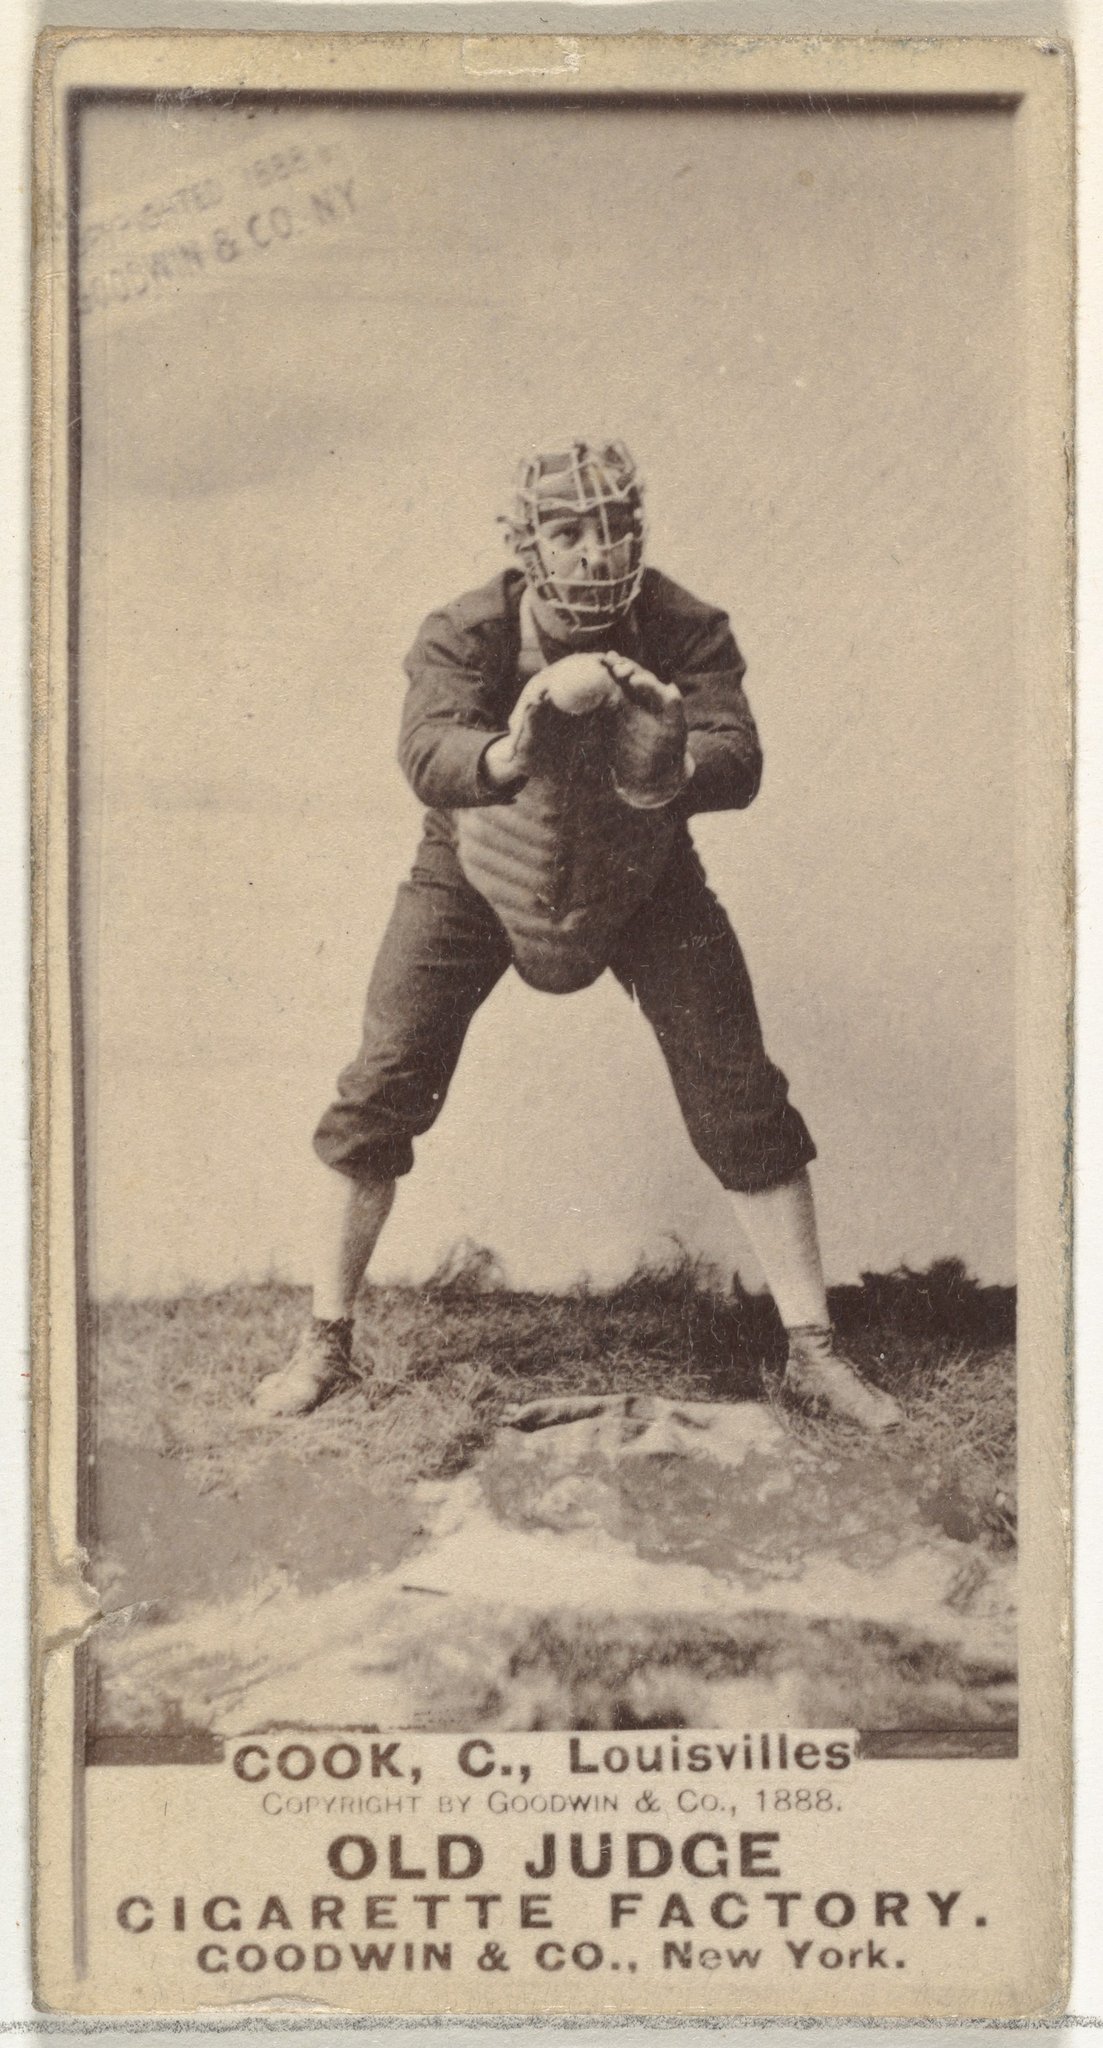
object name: baseball card, photograph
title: Paul Cook, Catcher, Louisville Colonels, from the Old Judge series (N172) for Old Judge Cigarettes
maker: goodwin & company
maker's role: publisher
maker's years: 1850-1950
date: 1888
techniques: albumen silver print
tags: men,portraits,baseball,athletes